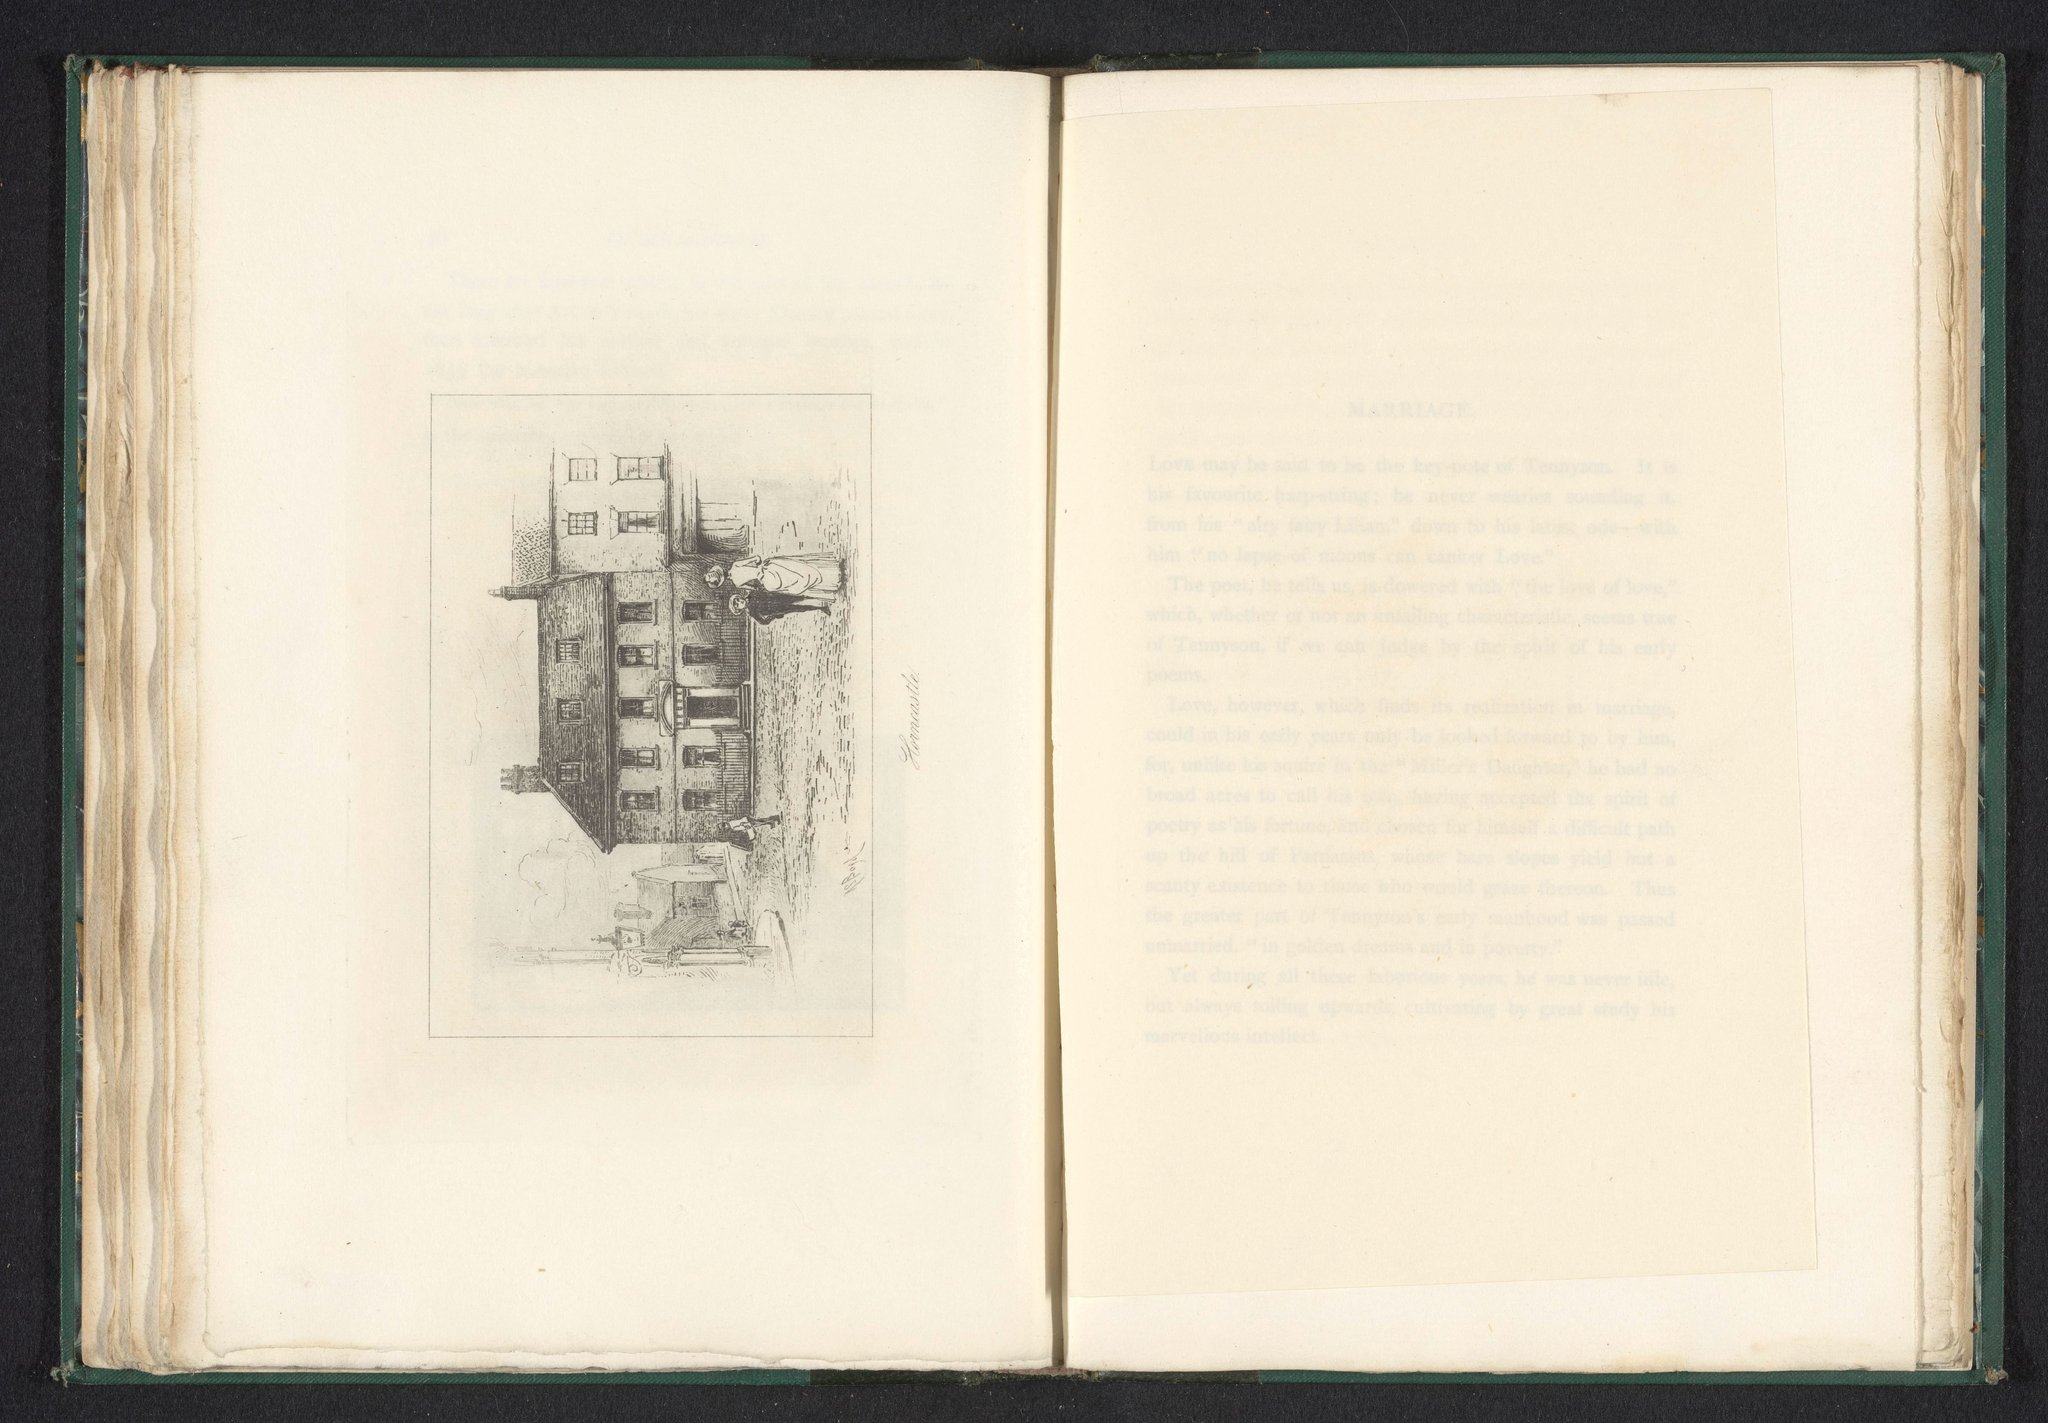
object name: page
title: Horncastle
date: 1884-1889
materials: paper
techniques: photoaquatint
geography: glasgow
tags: housing, façade (of house or building)